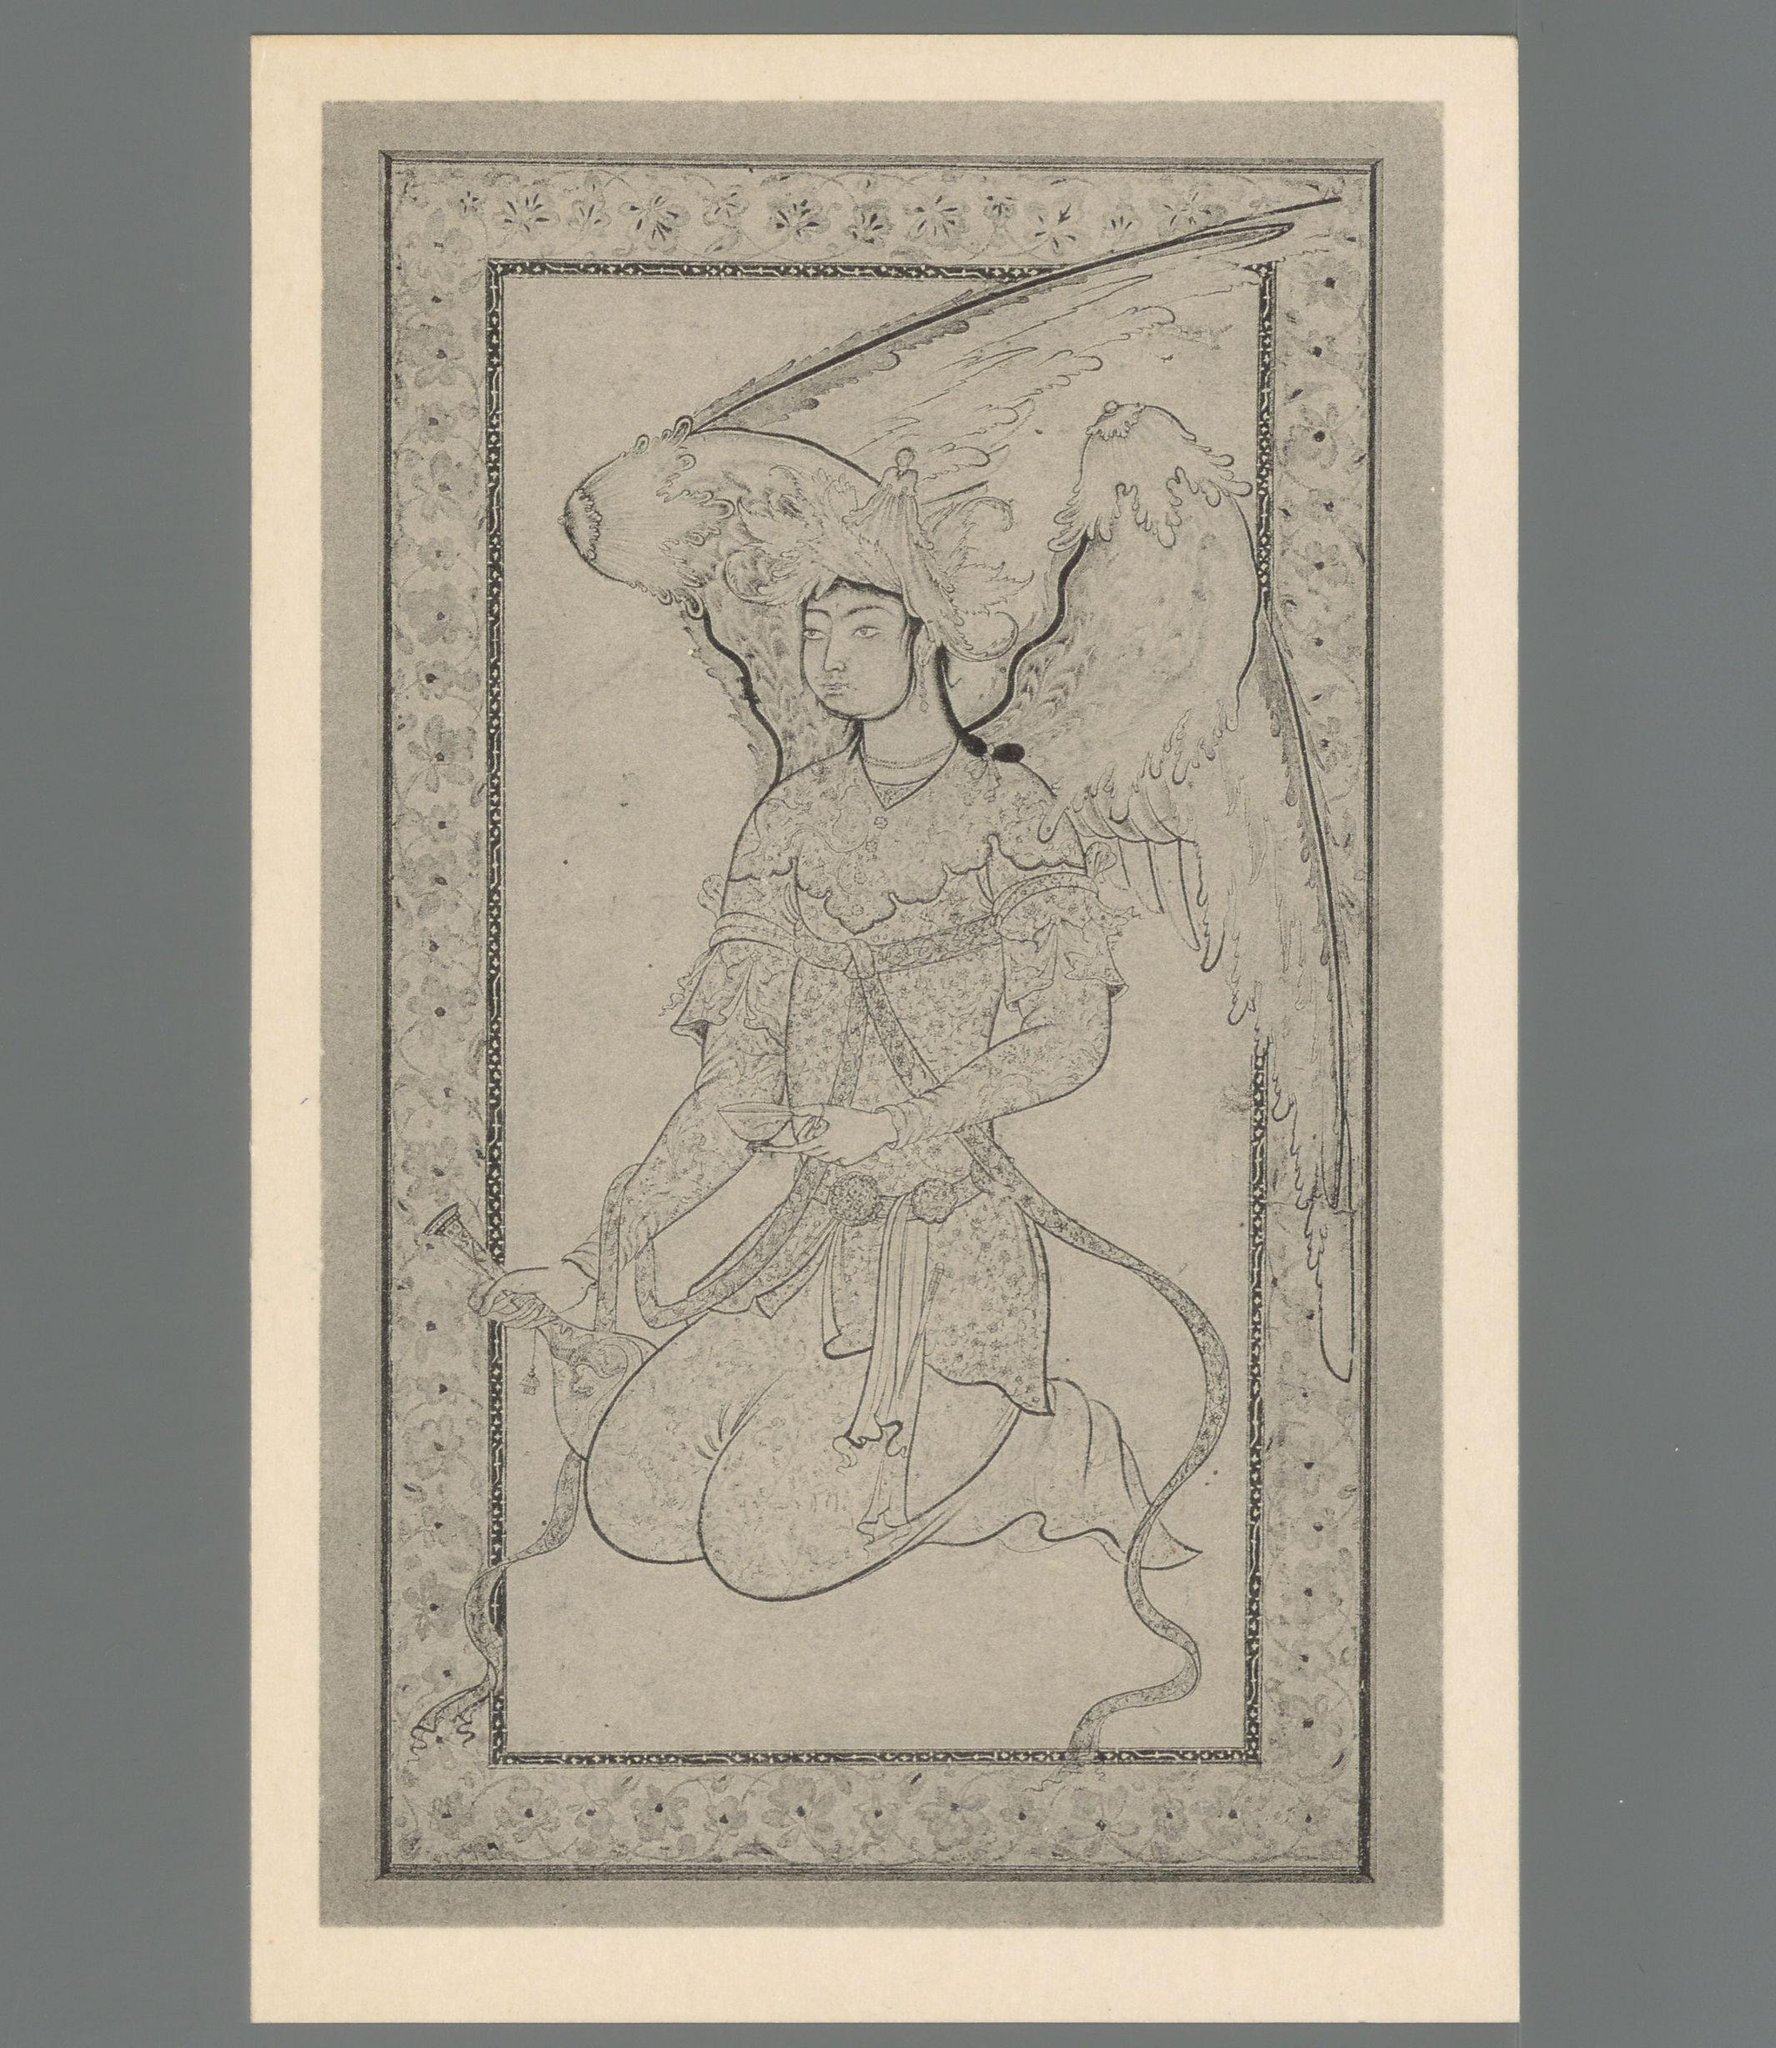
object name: reproduction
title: Kneeling figure of an angel as a cup-bearer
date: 1933-1950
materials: cardboard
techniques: photograph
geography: meriden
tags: painting ~ applied arts, cup, angels